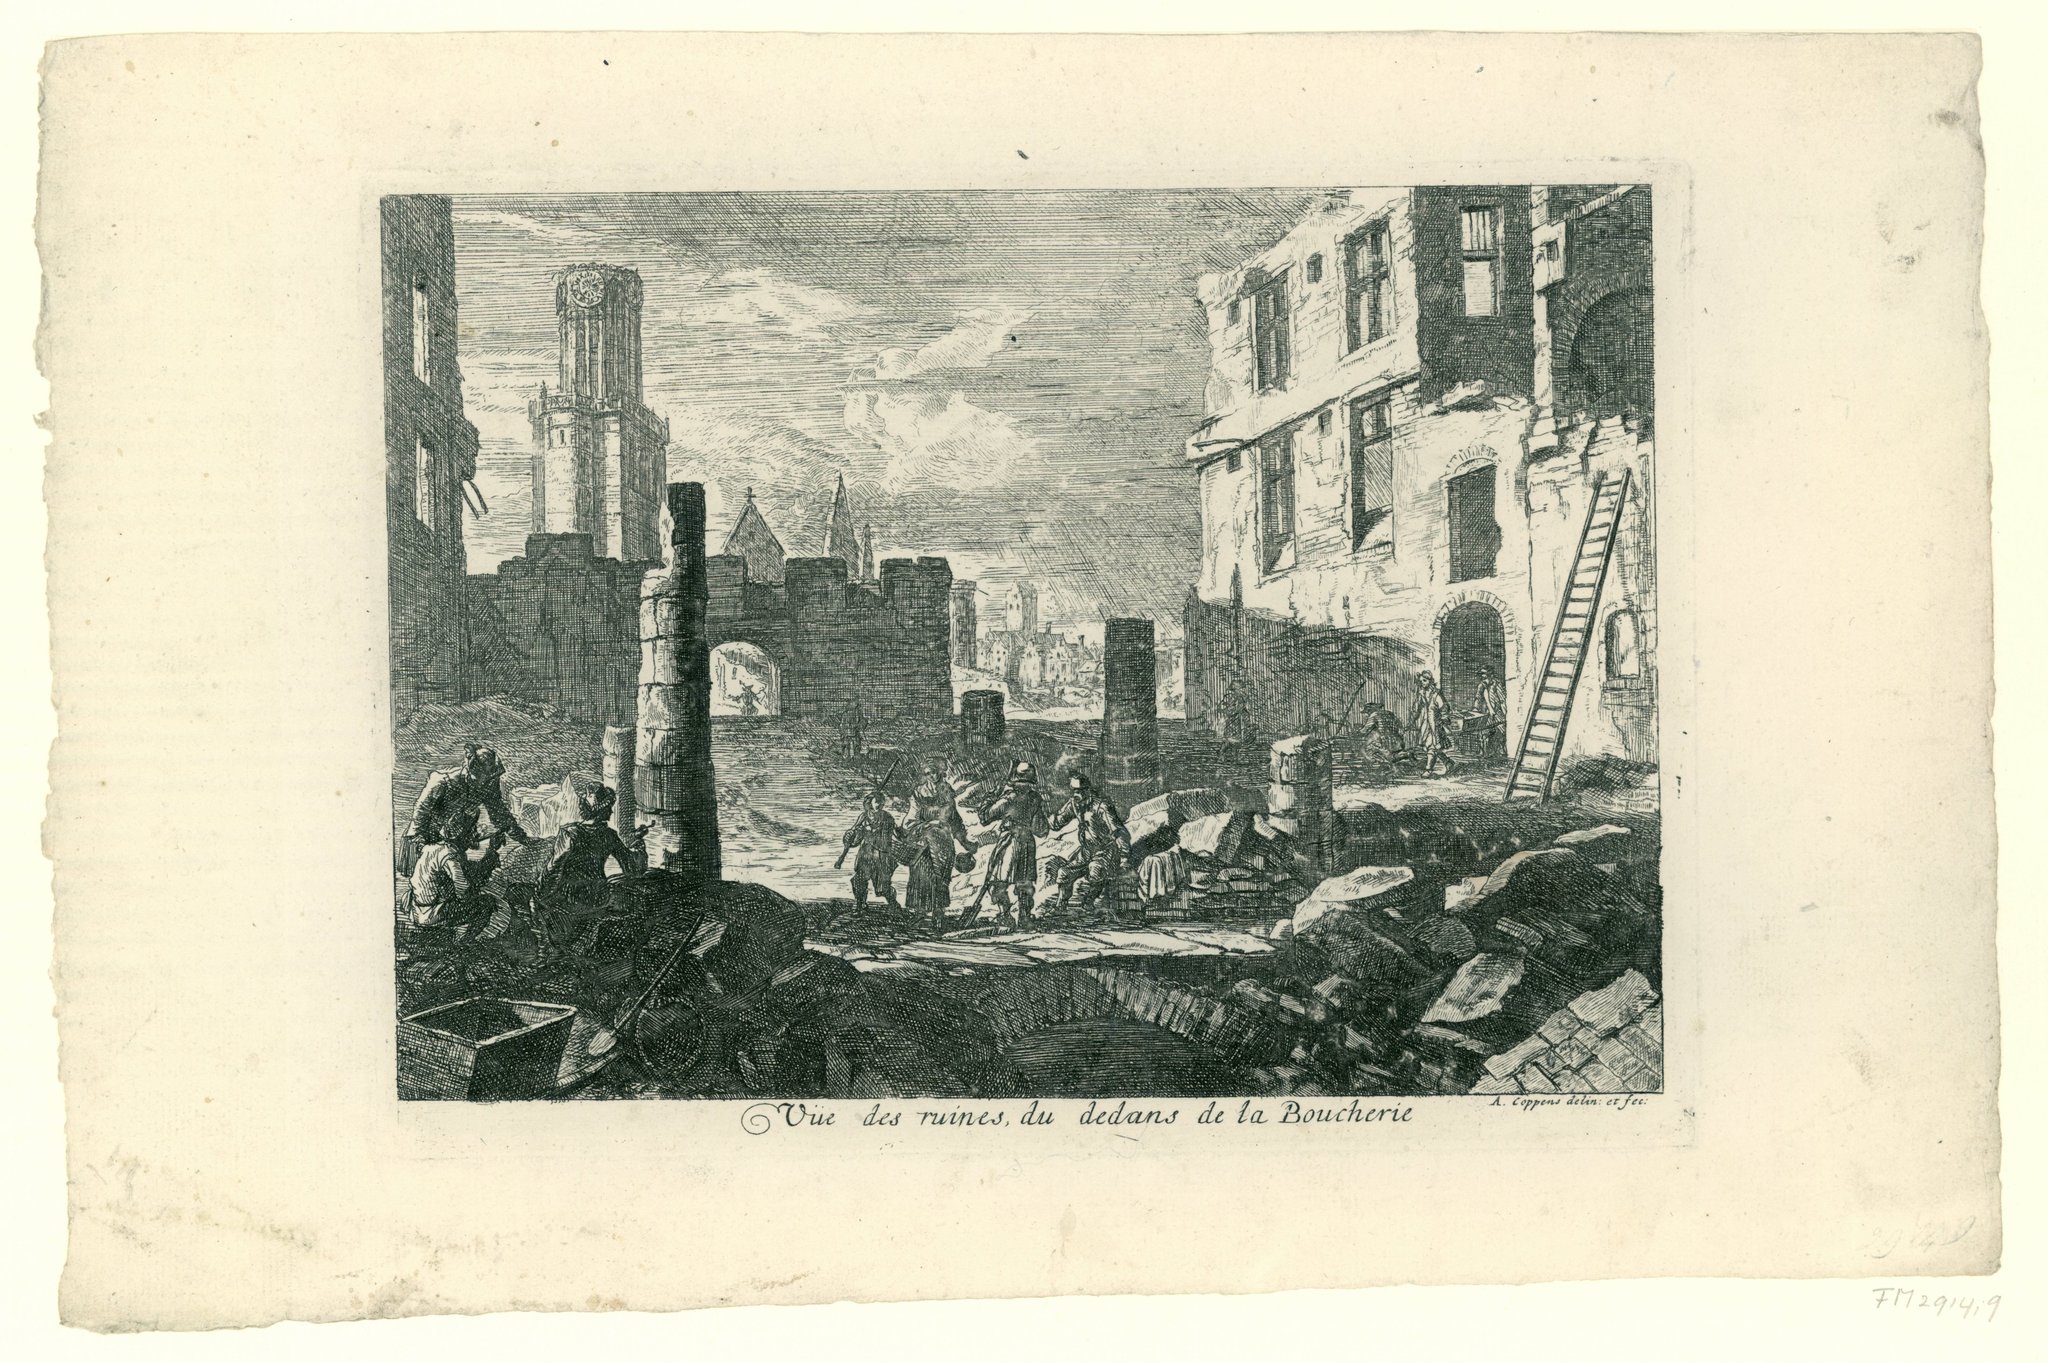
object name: print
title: Perspectives des ruines de la ville de Bruxelles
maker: augustin coppens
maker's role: print maker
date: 1695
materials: paper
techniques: etching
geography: southern netherlands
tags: devastated, ruined place or city (~ warfare), brussels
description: Voorstelling van de ruïnes in de Beenhouwersstraat te Brussel na het bombardement door de Fransen, 13-15 augustus 1695. Negende prent in de reeks van twaalf.